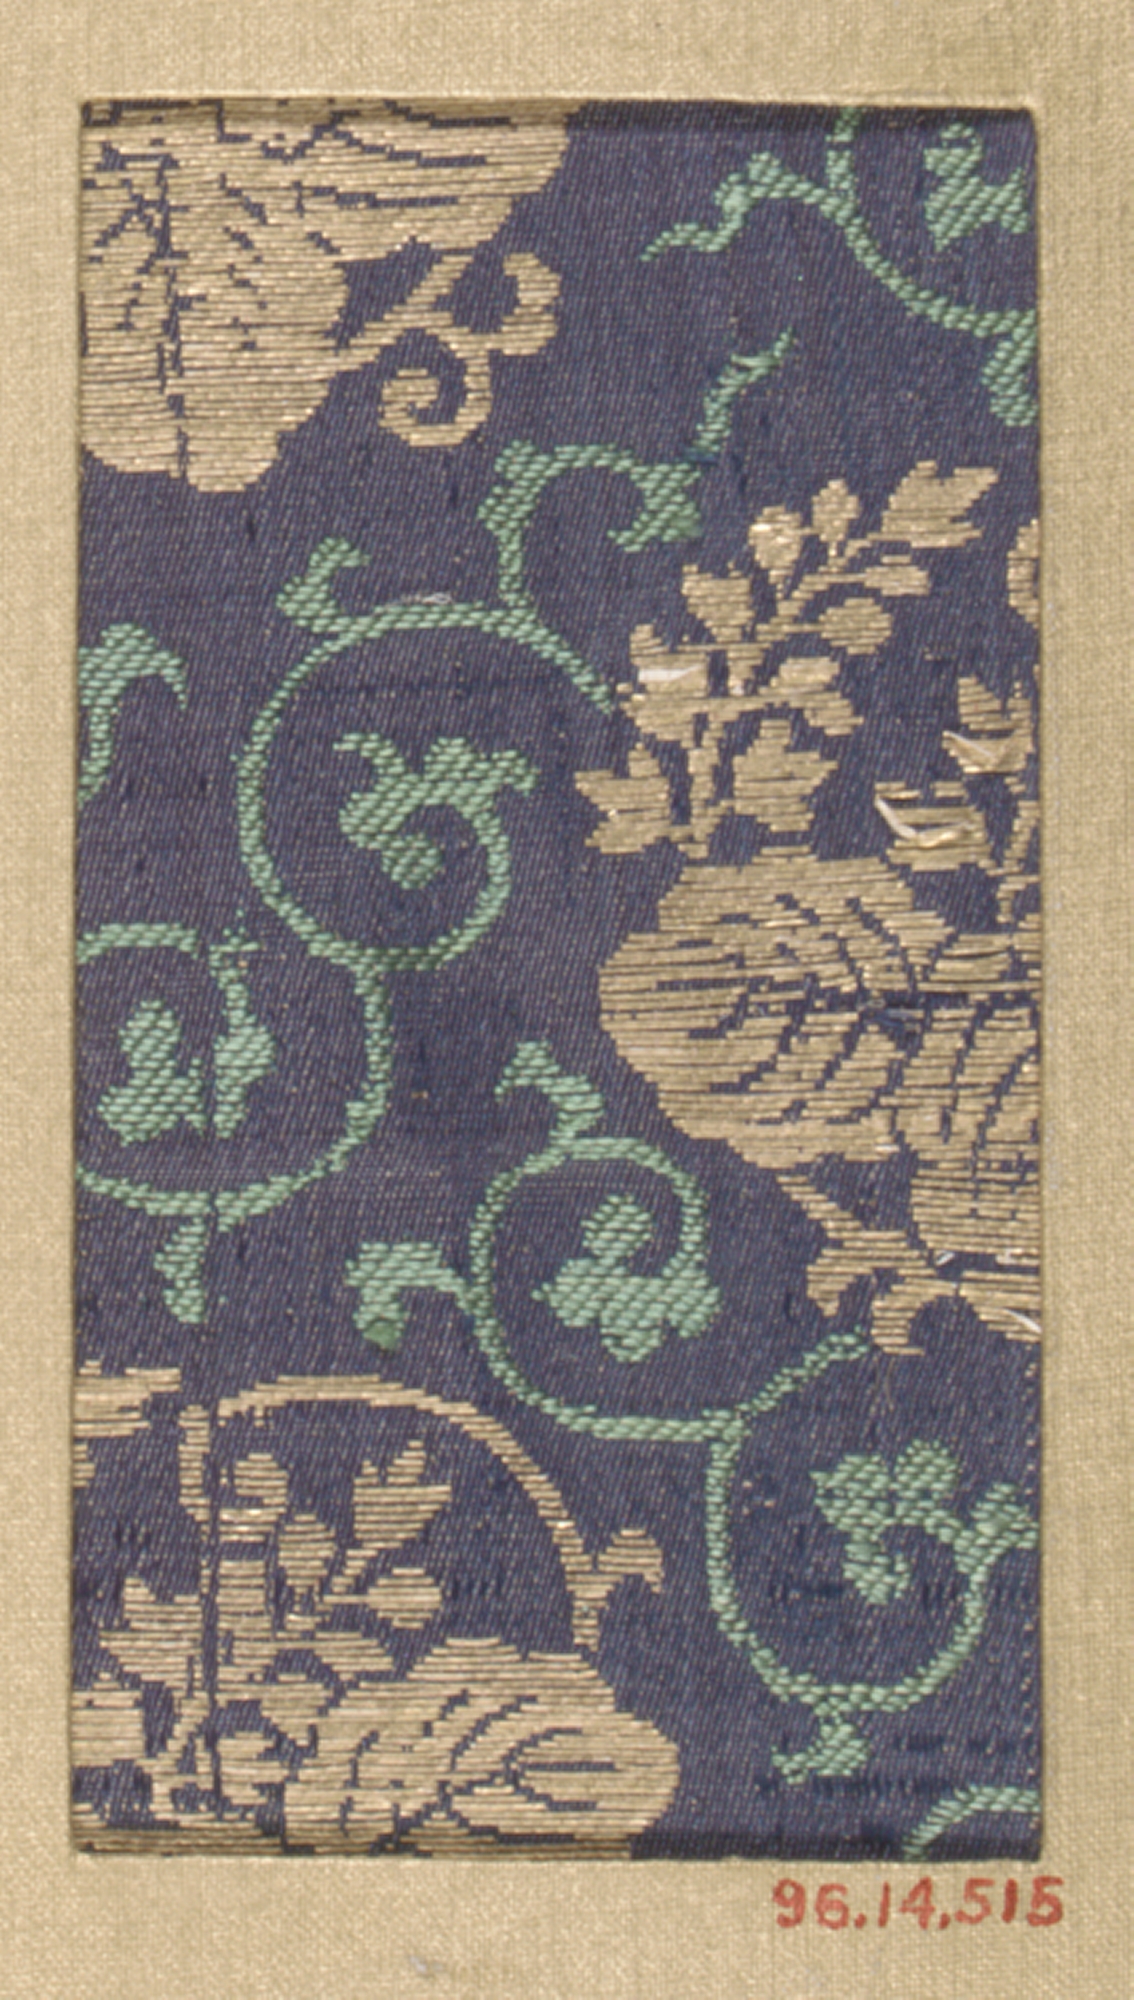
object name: piece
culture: japanese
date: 1701-1900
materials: metal thread, silk